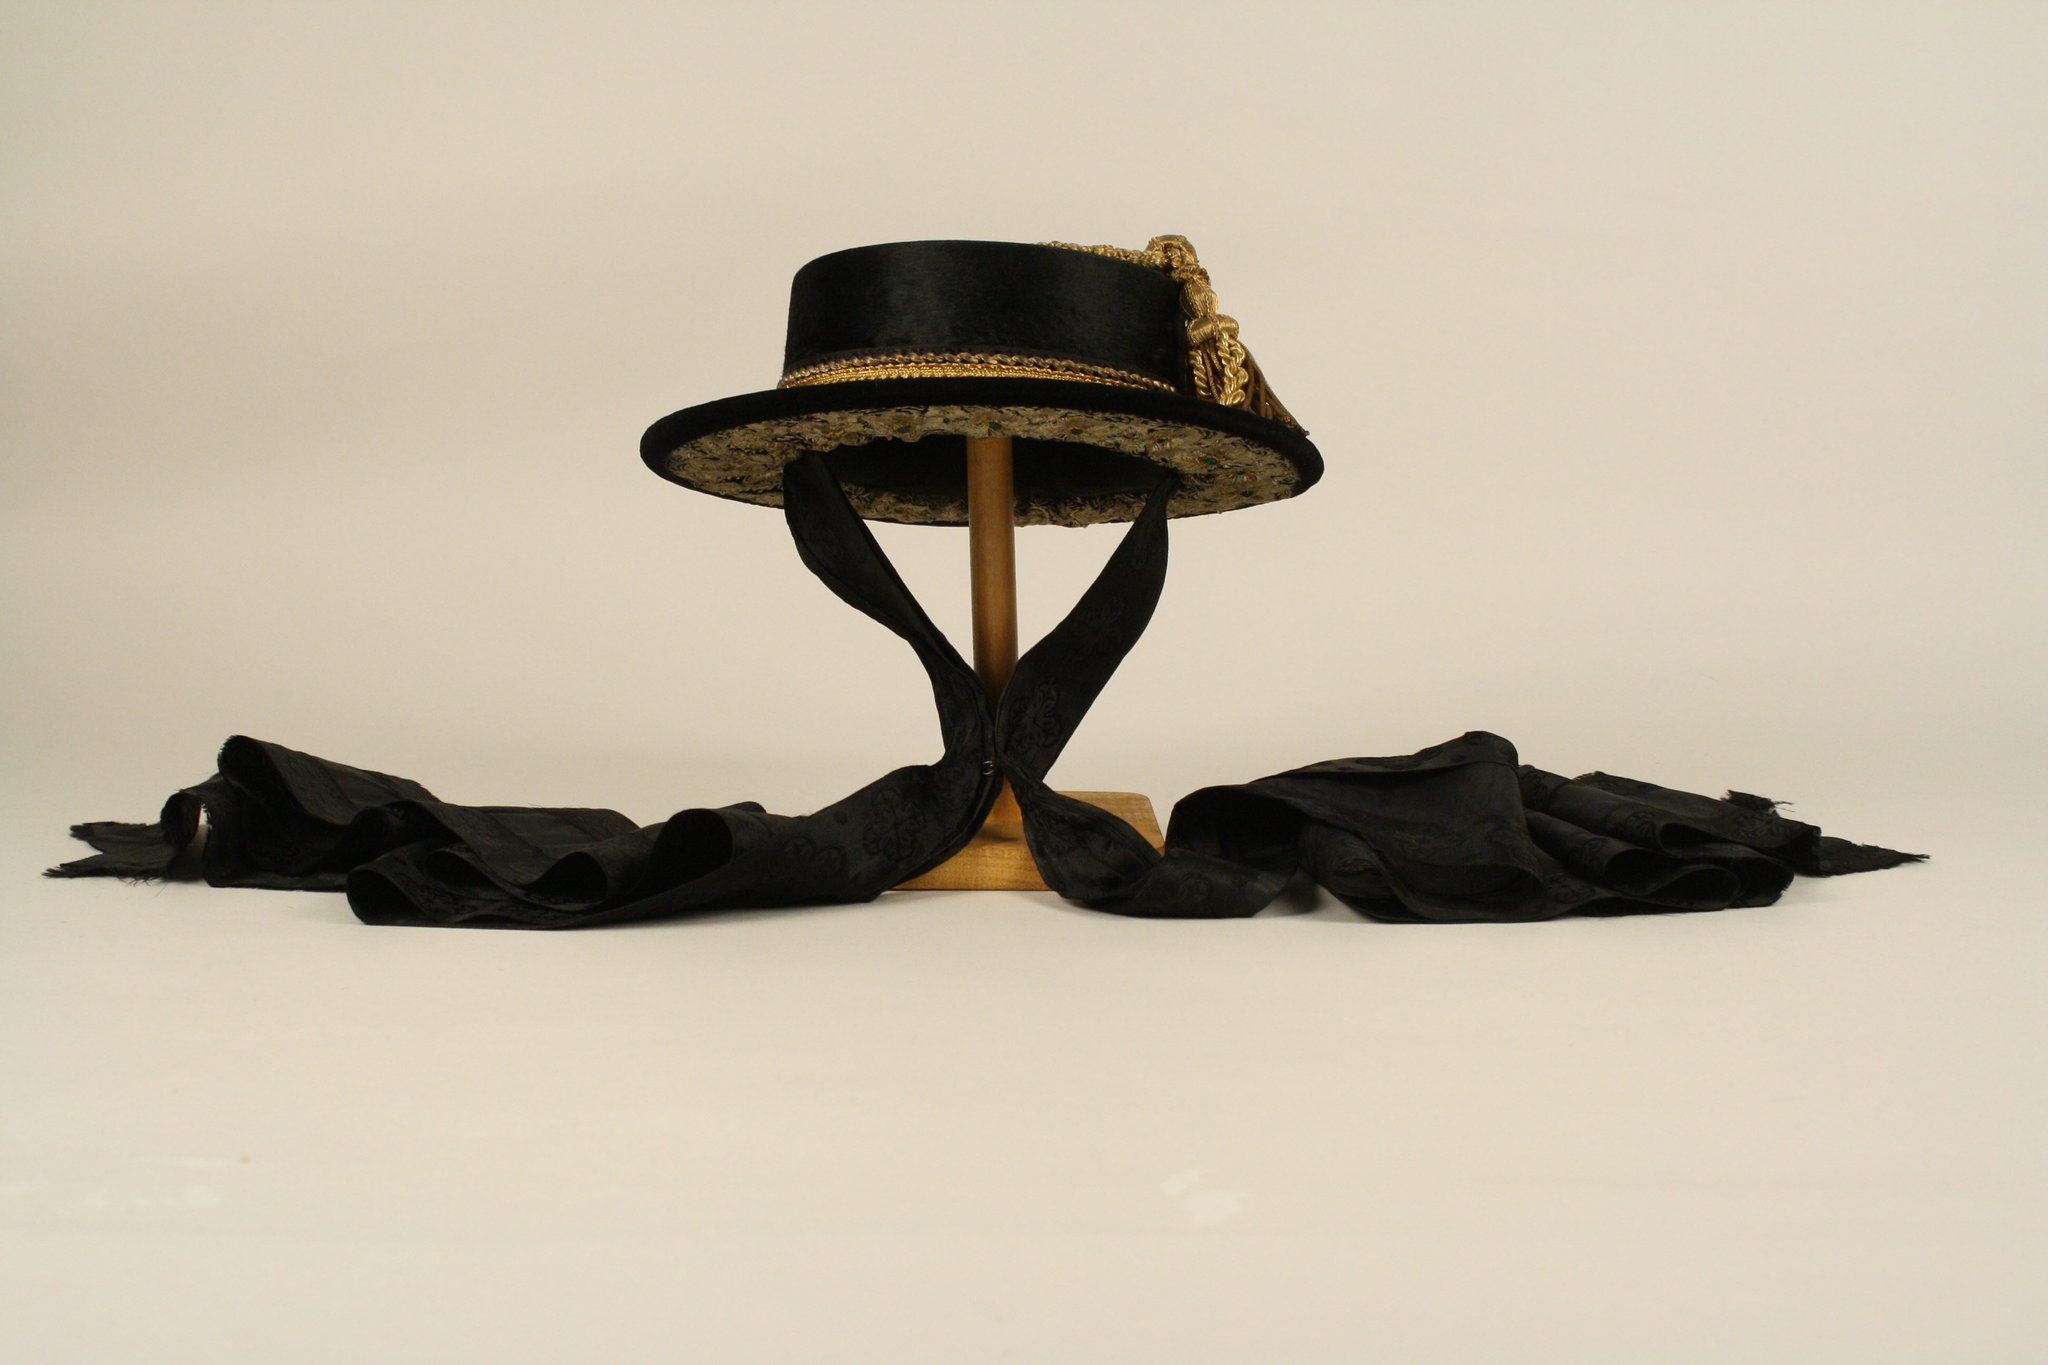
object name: headdress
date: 1801-1833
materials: metal thread, silk